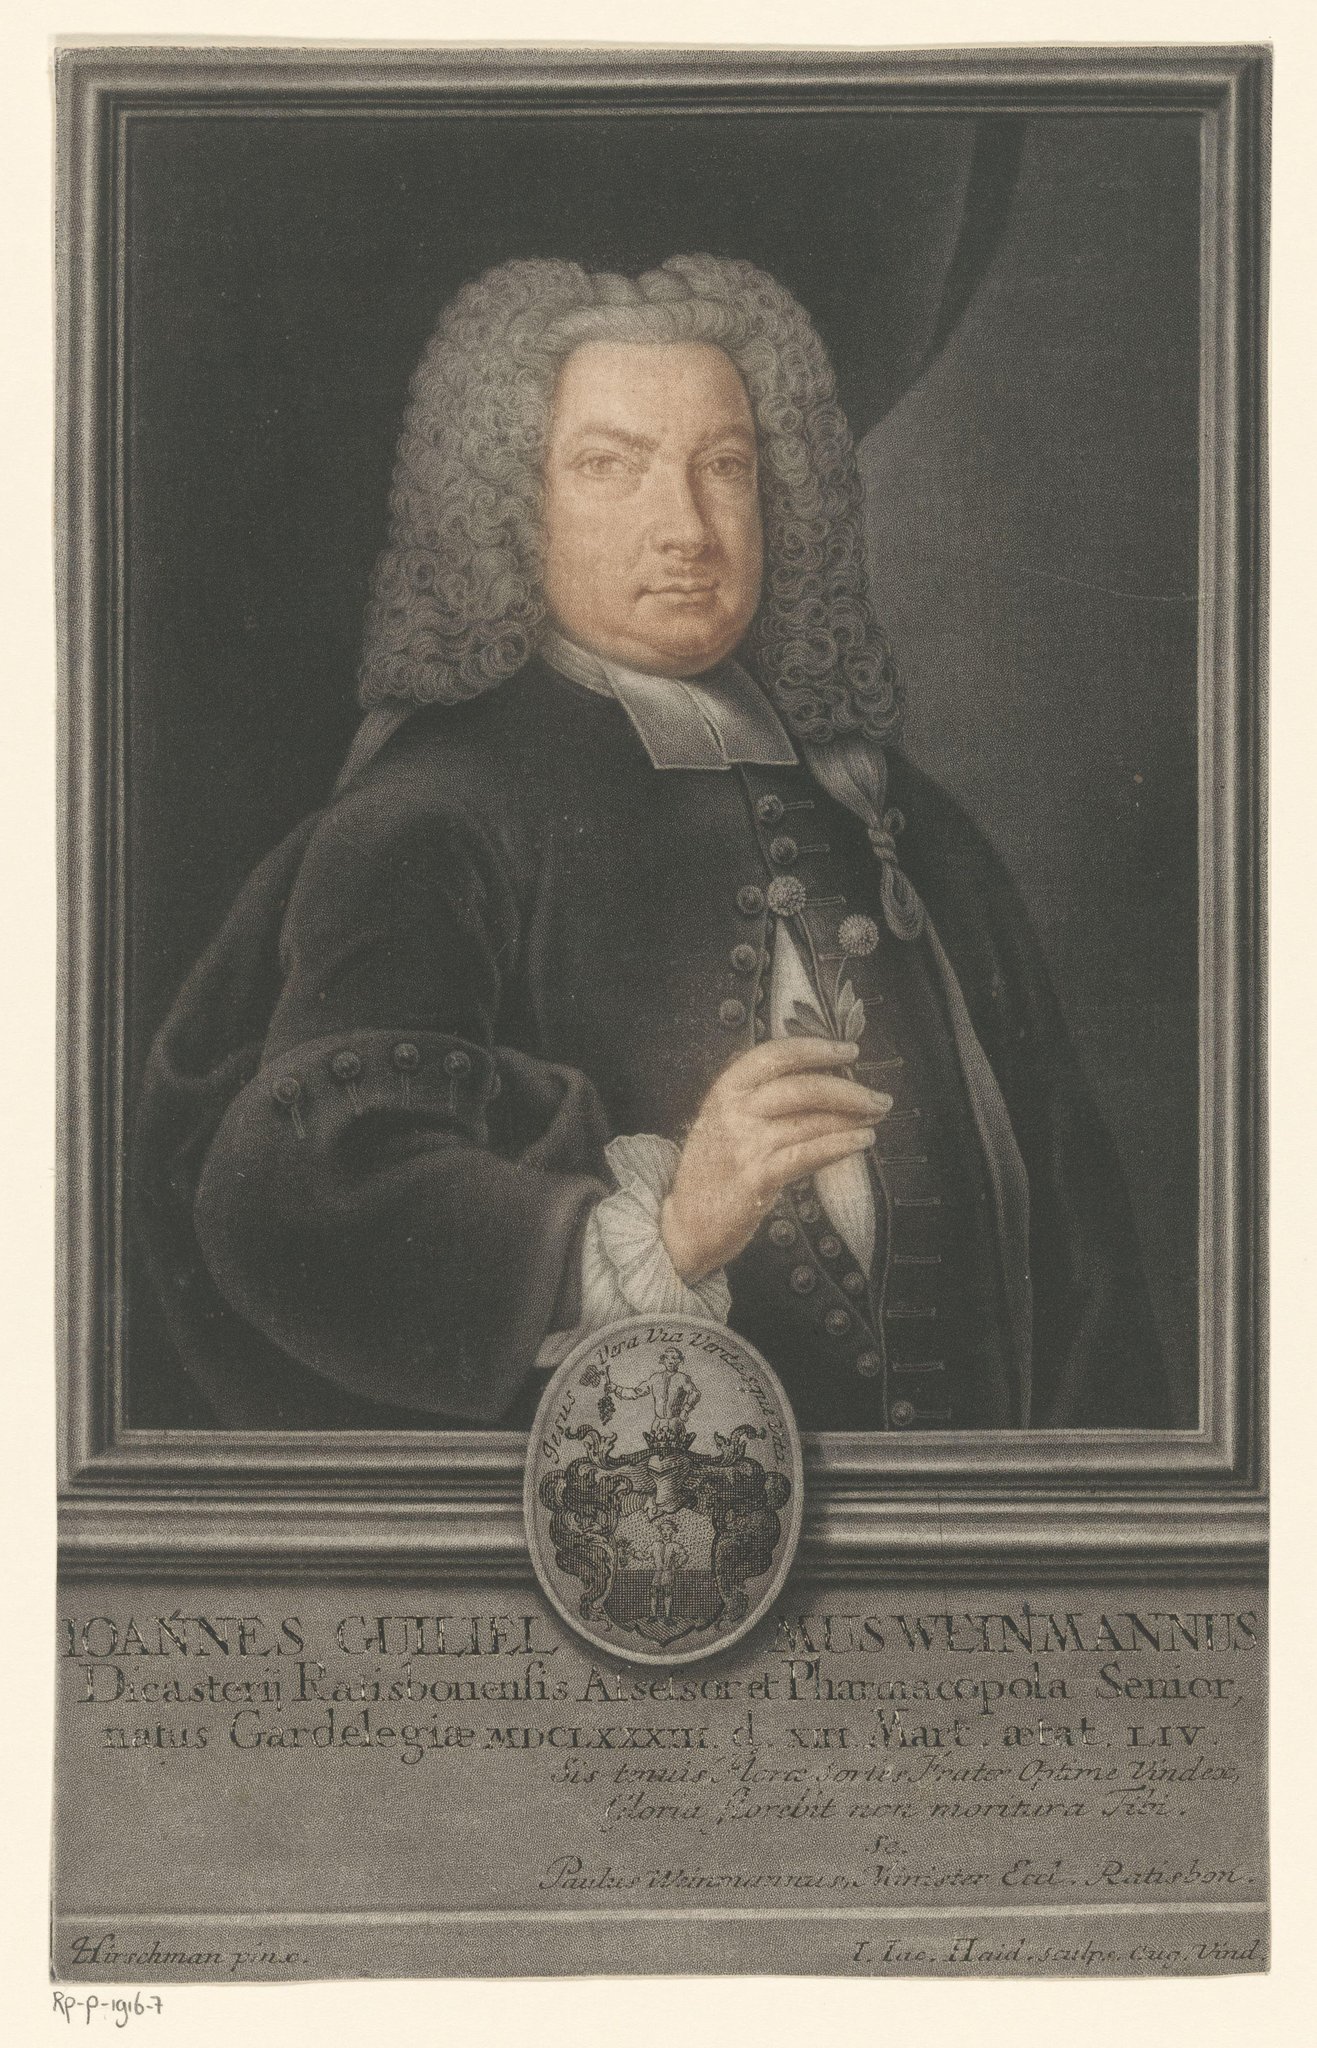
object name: print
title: Portret van Johann Wilhelm Weinmann op 54-jarige leeftijd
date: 1737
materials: paper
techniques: etching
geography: augsburg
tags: flowers: dandelion, historical persons, armorial bearing, heraldry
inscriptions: collector's mark: Lugt 2228